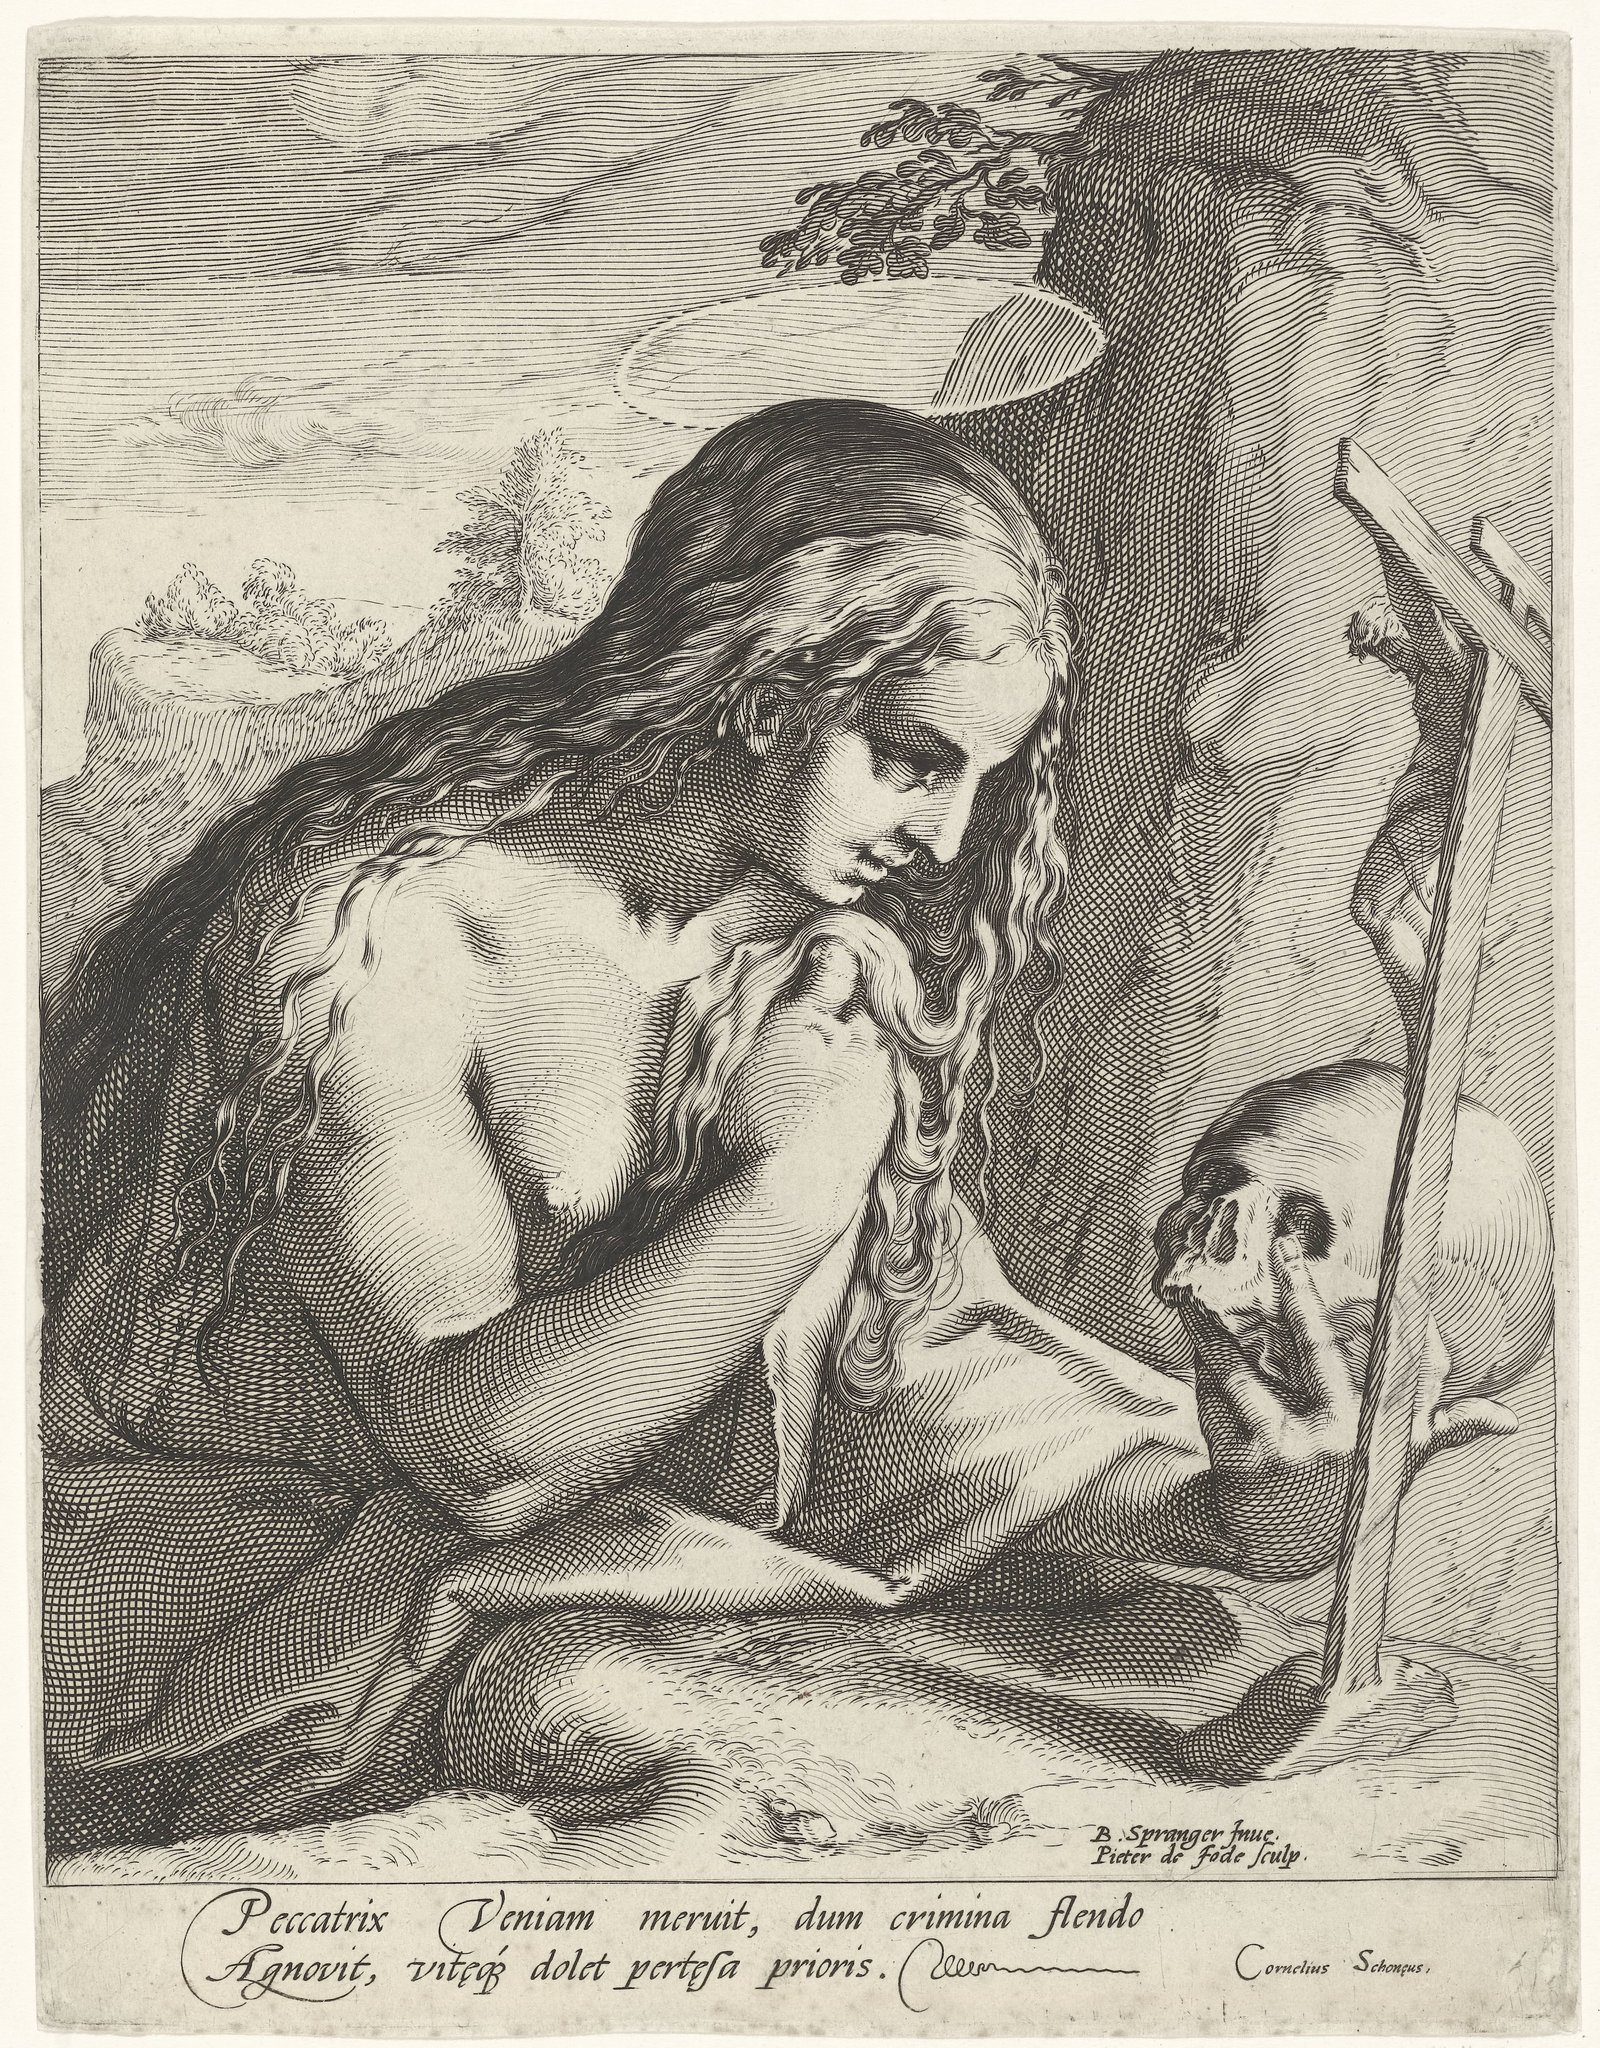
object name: print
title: De boetvaardige Maria Magdalena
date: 1590-1632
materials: paper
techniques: engraving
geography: antwerp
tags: the penitent harlot mary magdalene; possible attributes: book (or scroll), crown, crown of thorns, crucifix, jar of ointment, mirror, musical instrument, palm-branch, rosary, scourge - apotheosis, glory, triumph of female saint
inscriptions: collector's mark: Lugt 240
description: Landschap met de boetvaardige Maria Magdalena. Met haar rechterhand houdt zij haar lange haren vast. In haar linkerhand houdt zij een schedel. Voor haar een crucifix. In de marge een tweeregelig onderschrift in het Latijn.